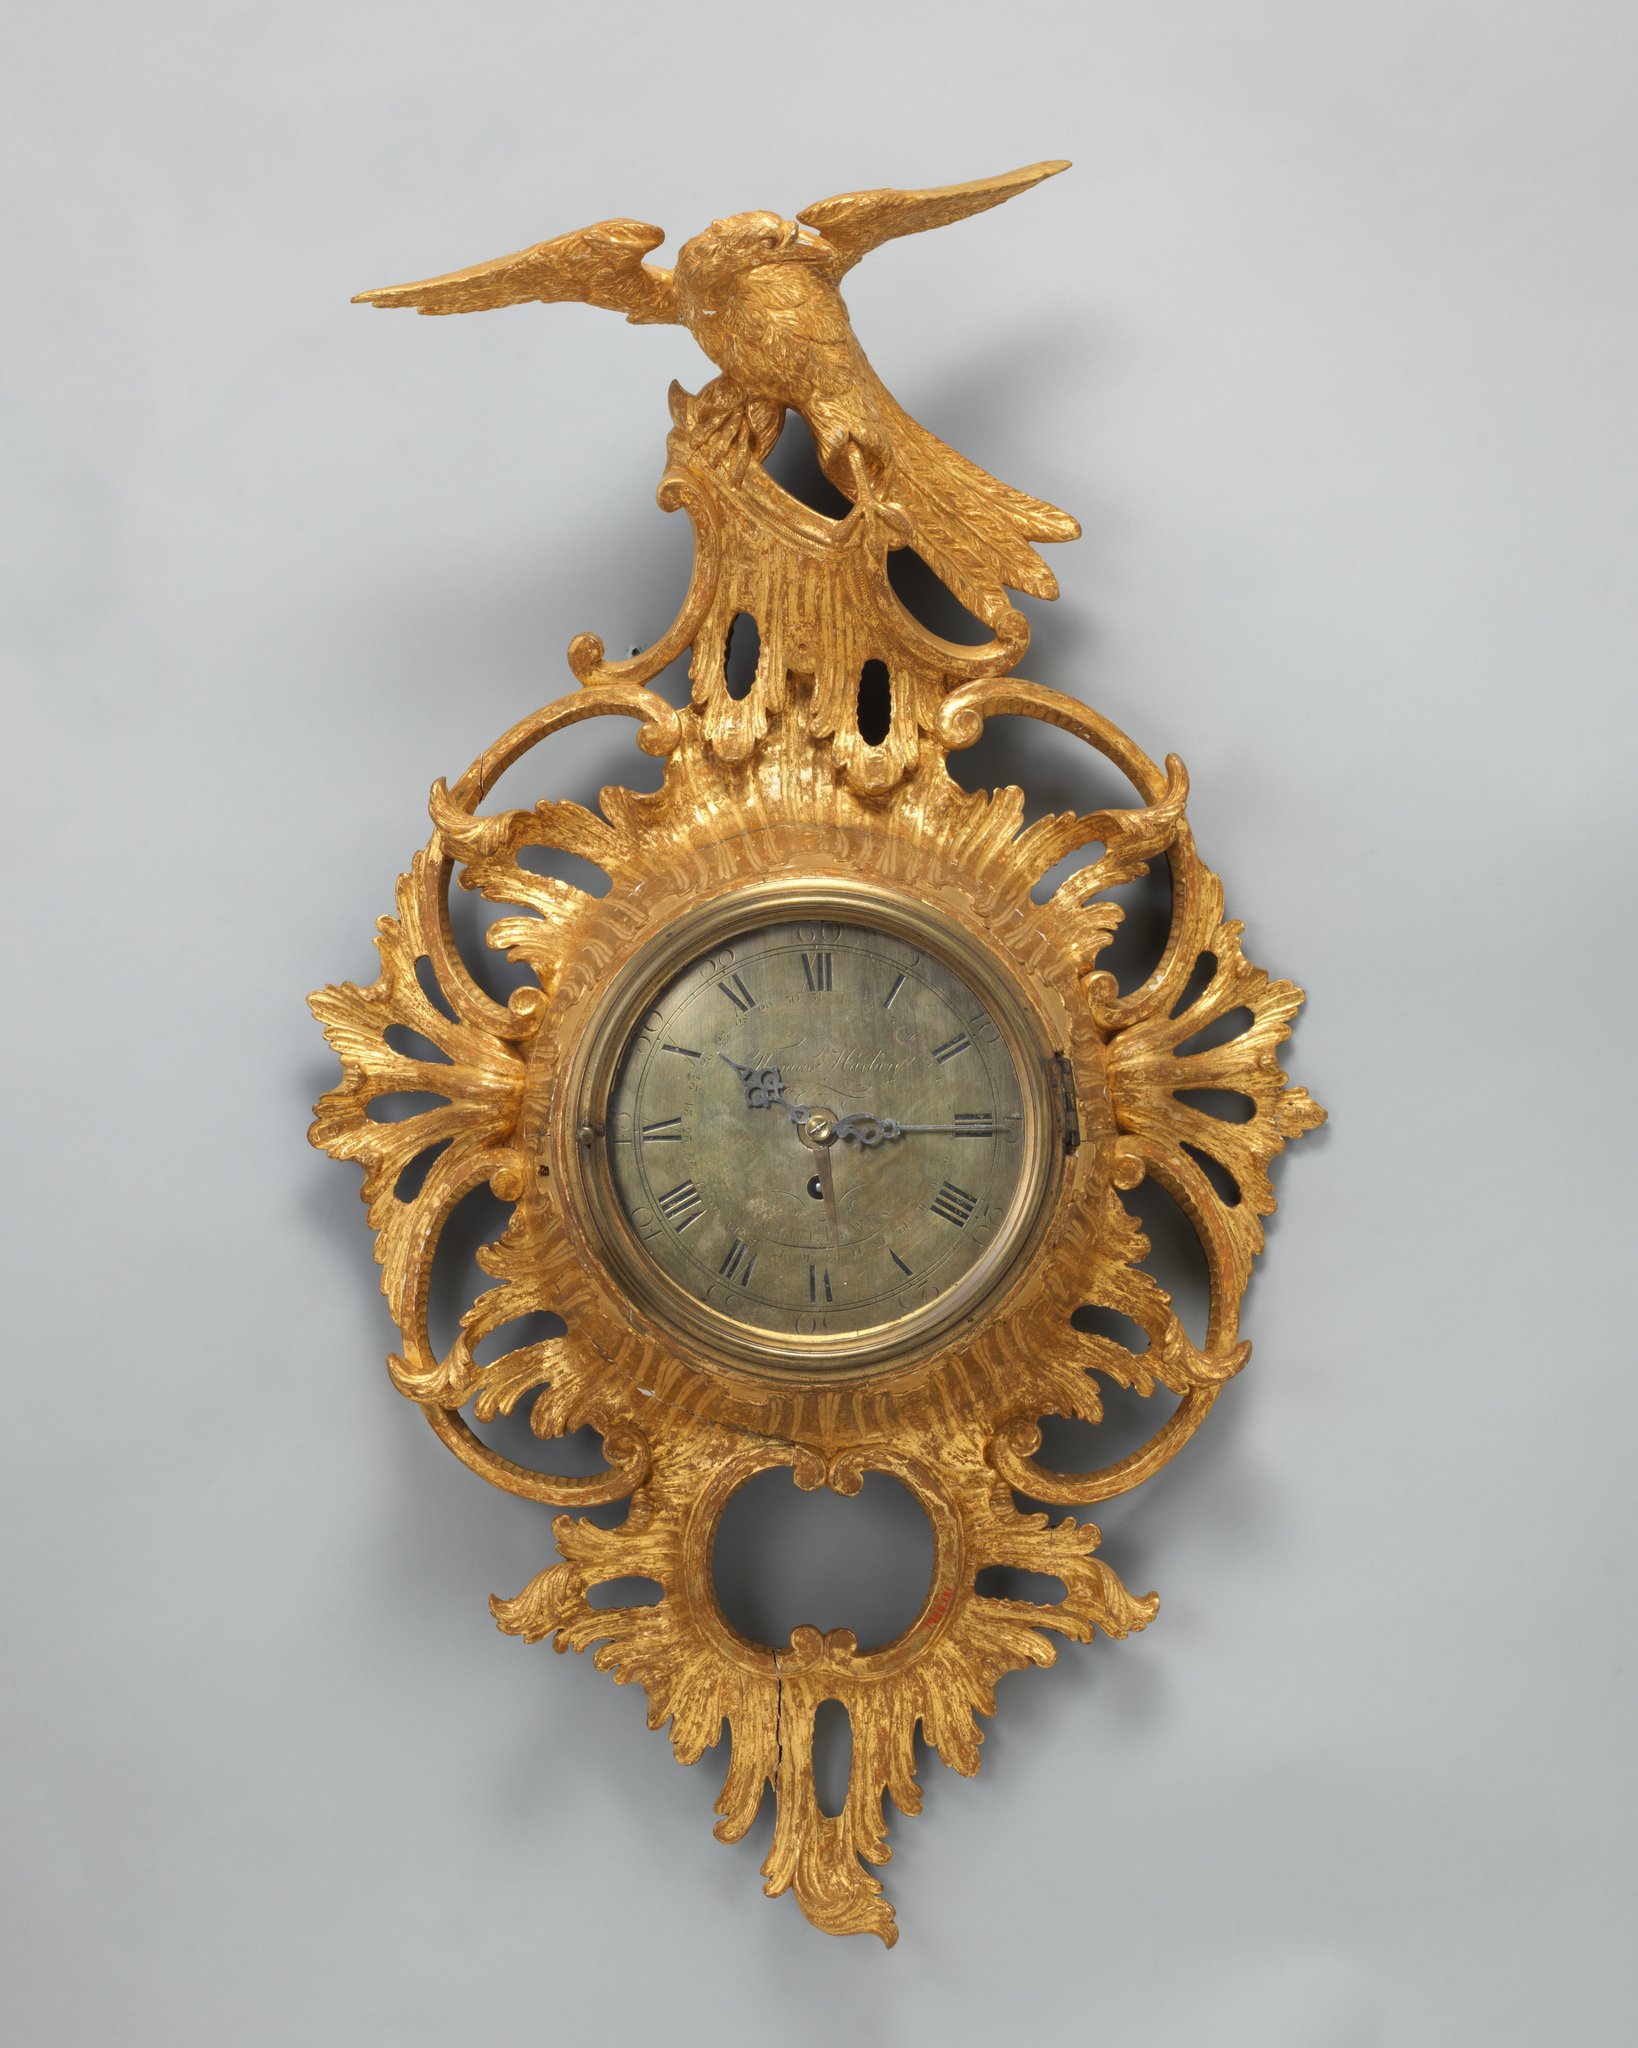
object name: wall clock with calendar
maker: thomas harben ii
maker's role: maker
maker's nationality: british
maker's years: 1739-1803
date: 1775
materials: brass, wood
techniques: carving, gilding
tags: birds